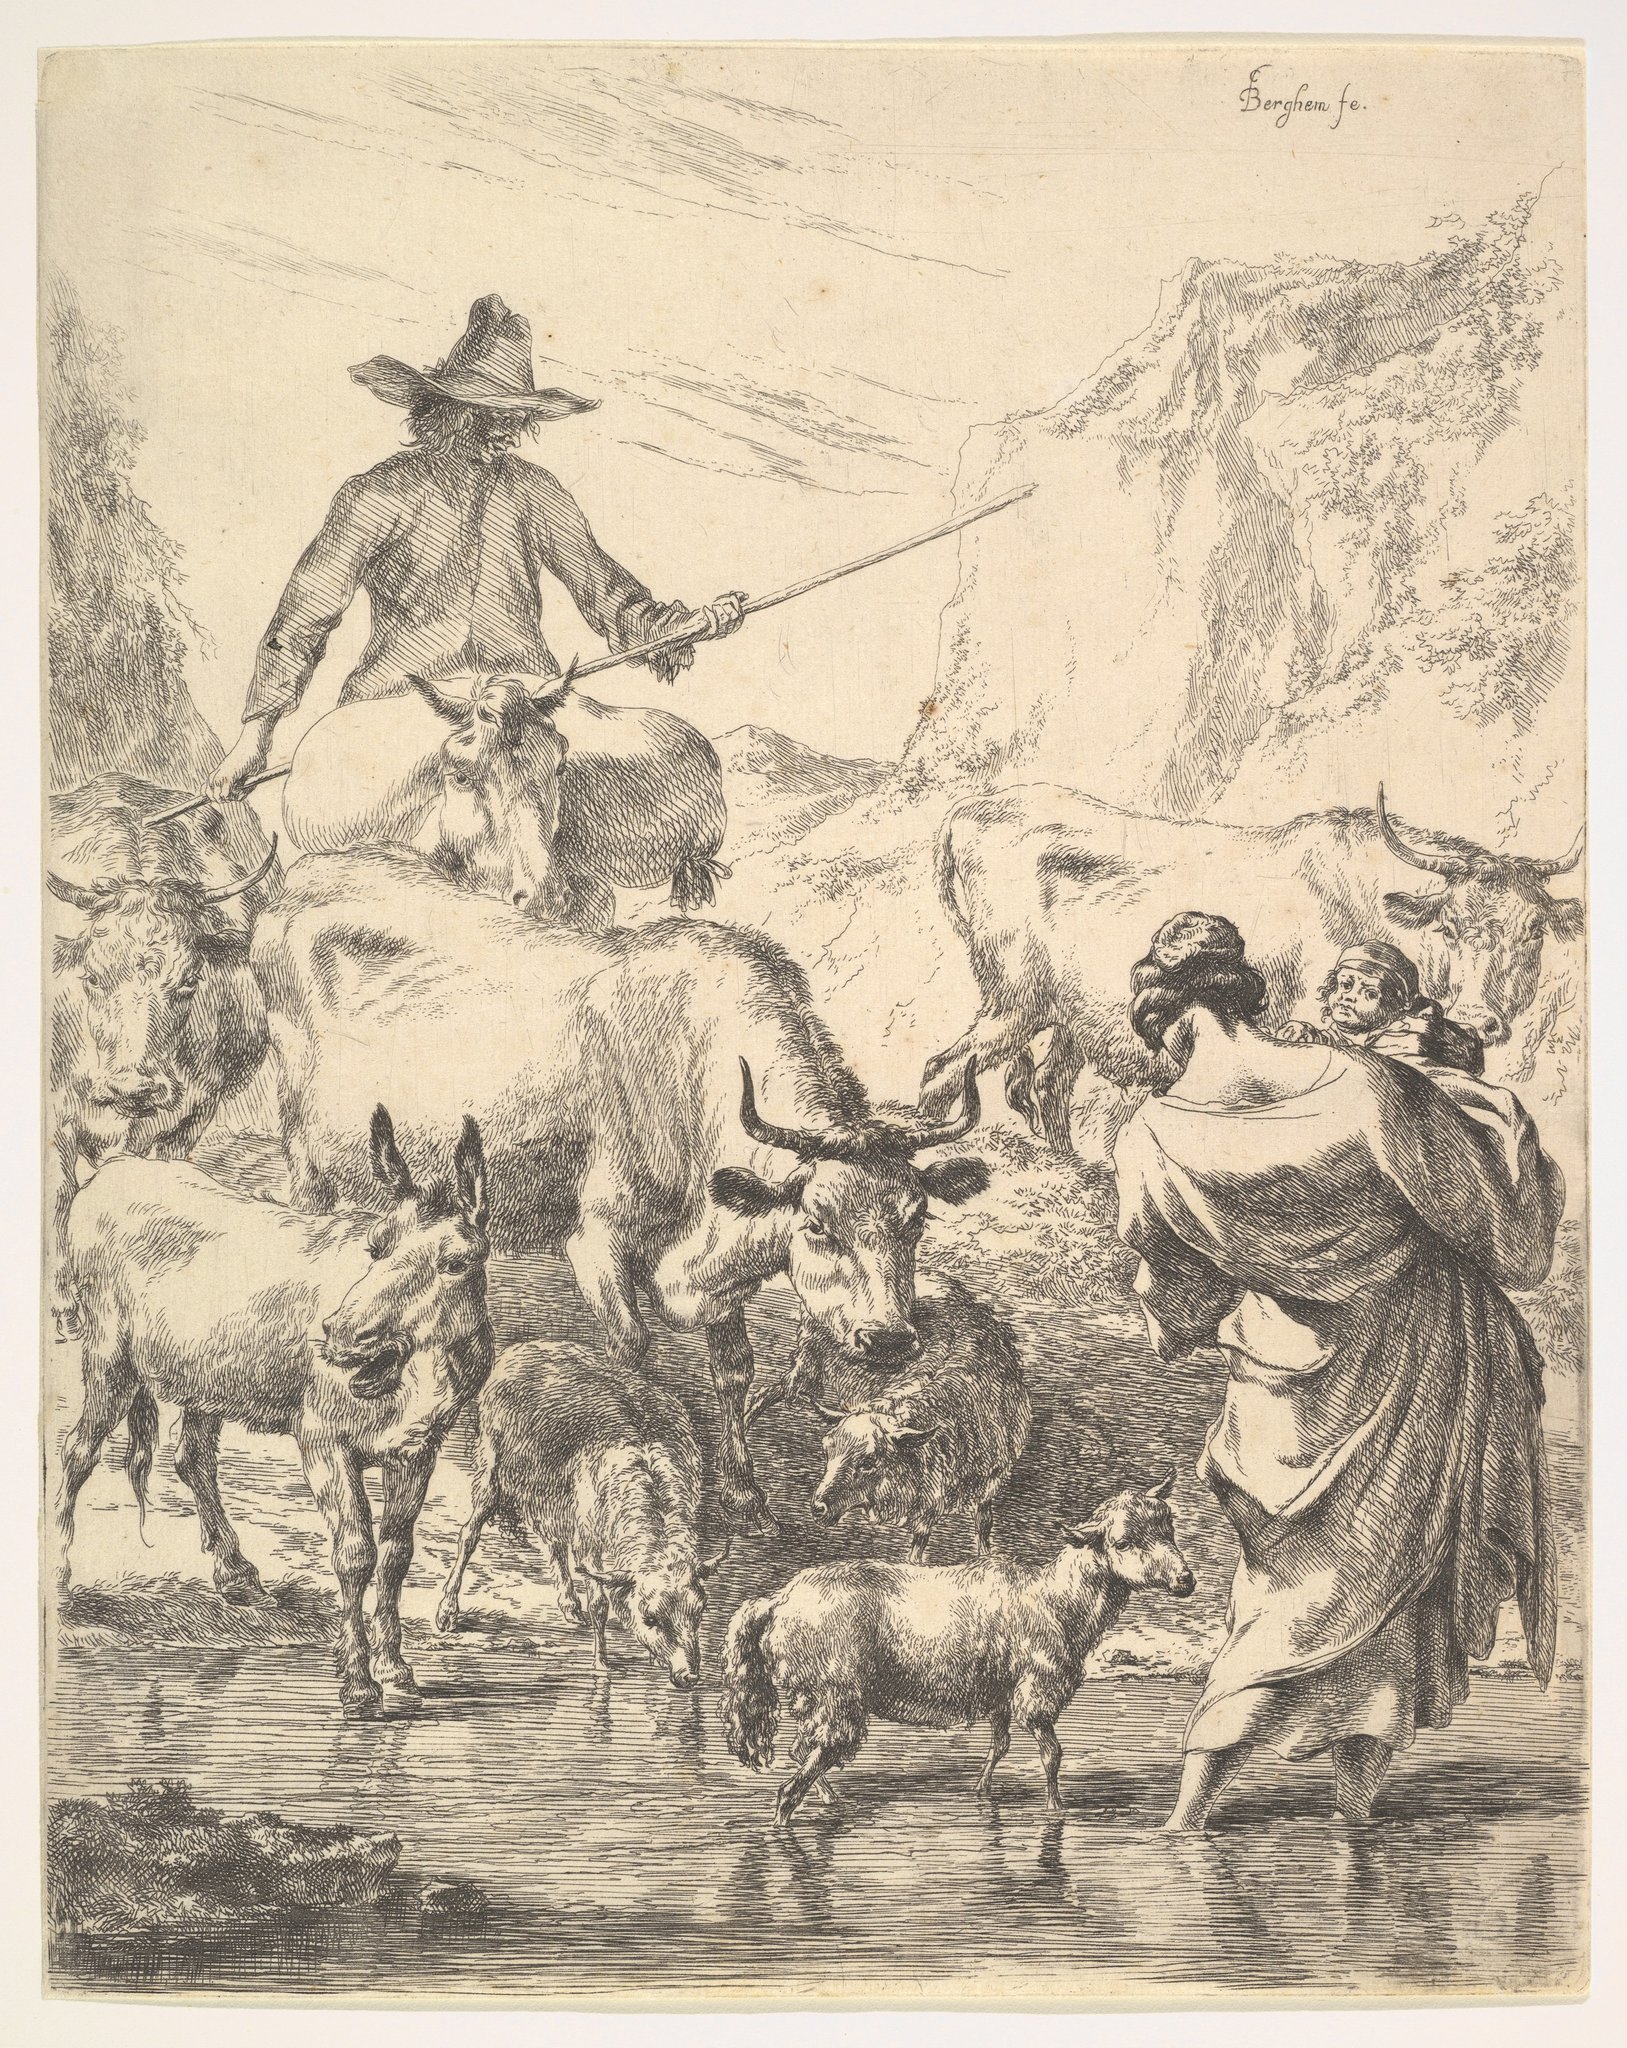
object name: print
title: Le Troupeau Traversant Le Ruisseau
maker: nicolaes pietersz berchem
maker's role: artist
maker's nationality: dutch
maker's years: 1620-1683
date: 1630-1683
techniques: etching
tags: animals,infants,men,women,cows,sheep